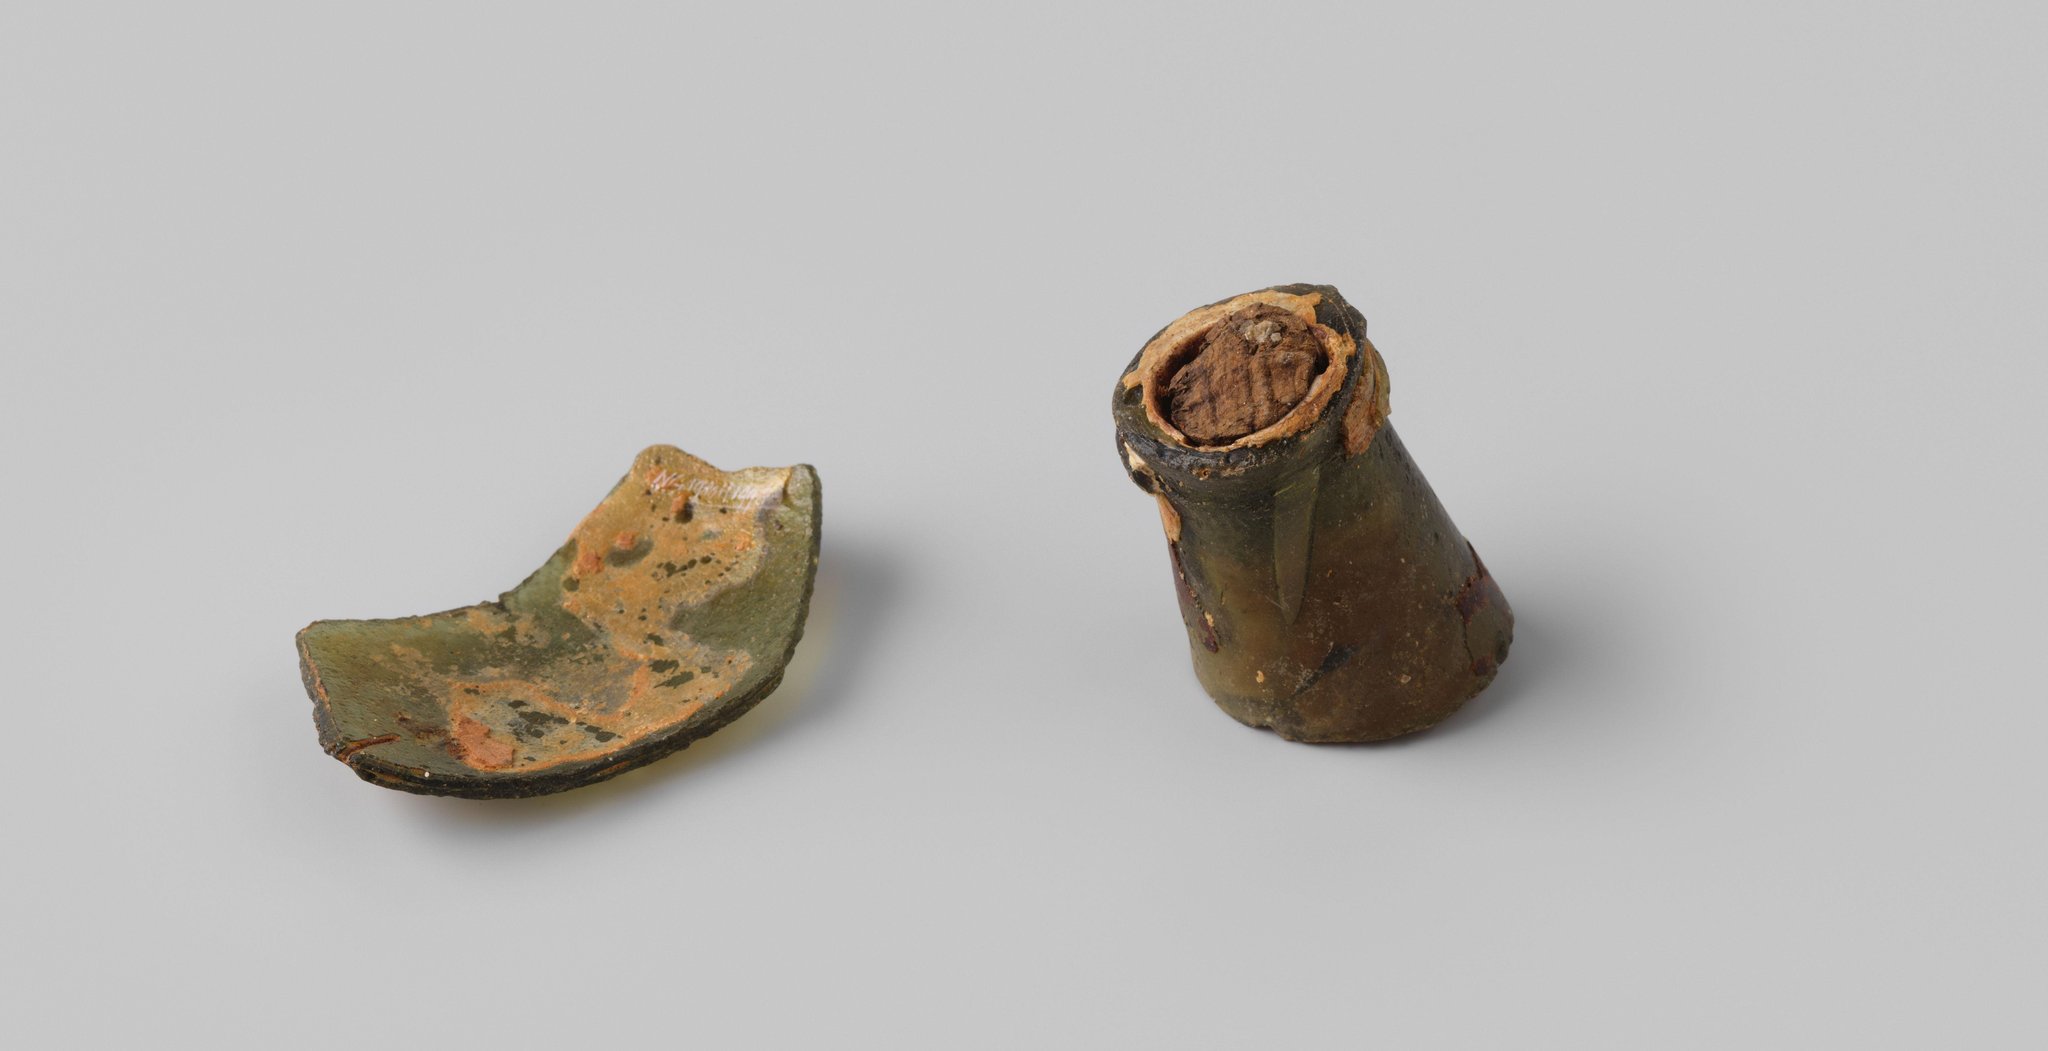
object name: wine bottle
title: Hals met kurk van een wijnfles en een glasscherf uit het wrak van de Oost-Indiëvaarder Hollandia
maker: Anonymous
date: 1700-1743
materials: cork, glass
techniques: green glass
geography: netherlands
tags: verenigde oostindische compagnie, hollandia (schip), annet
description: Wine bottle, continental production, neck, onion-shaped bottle or bottle with vertical side; fragm, vs-string rim, projecting cork.